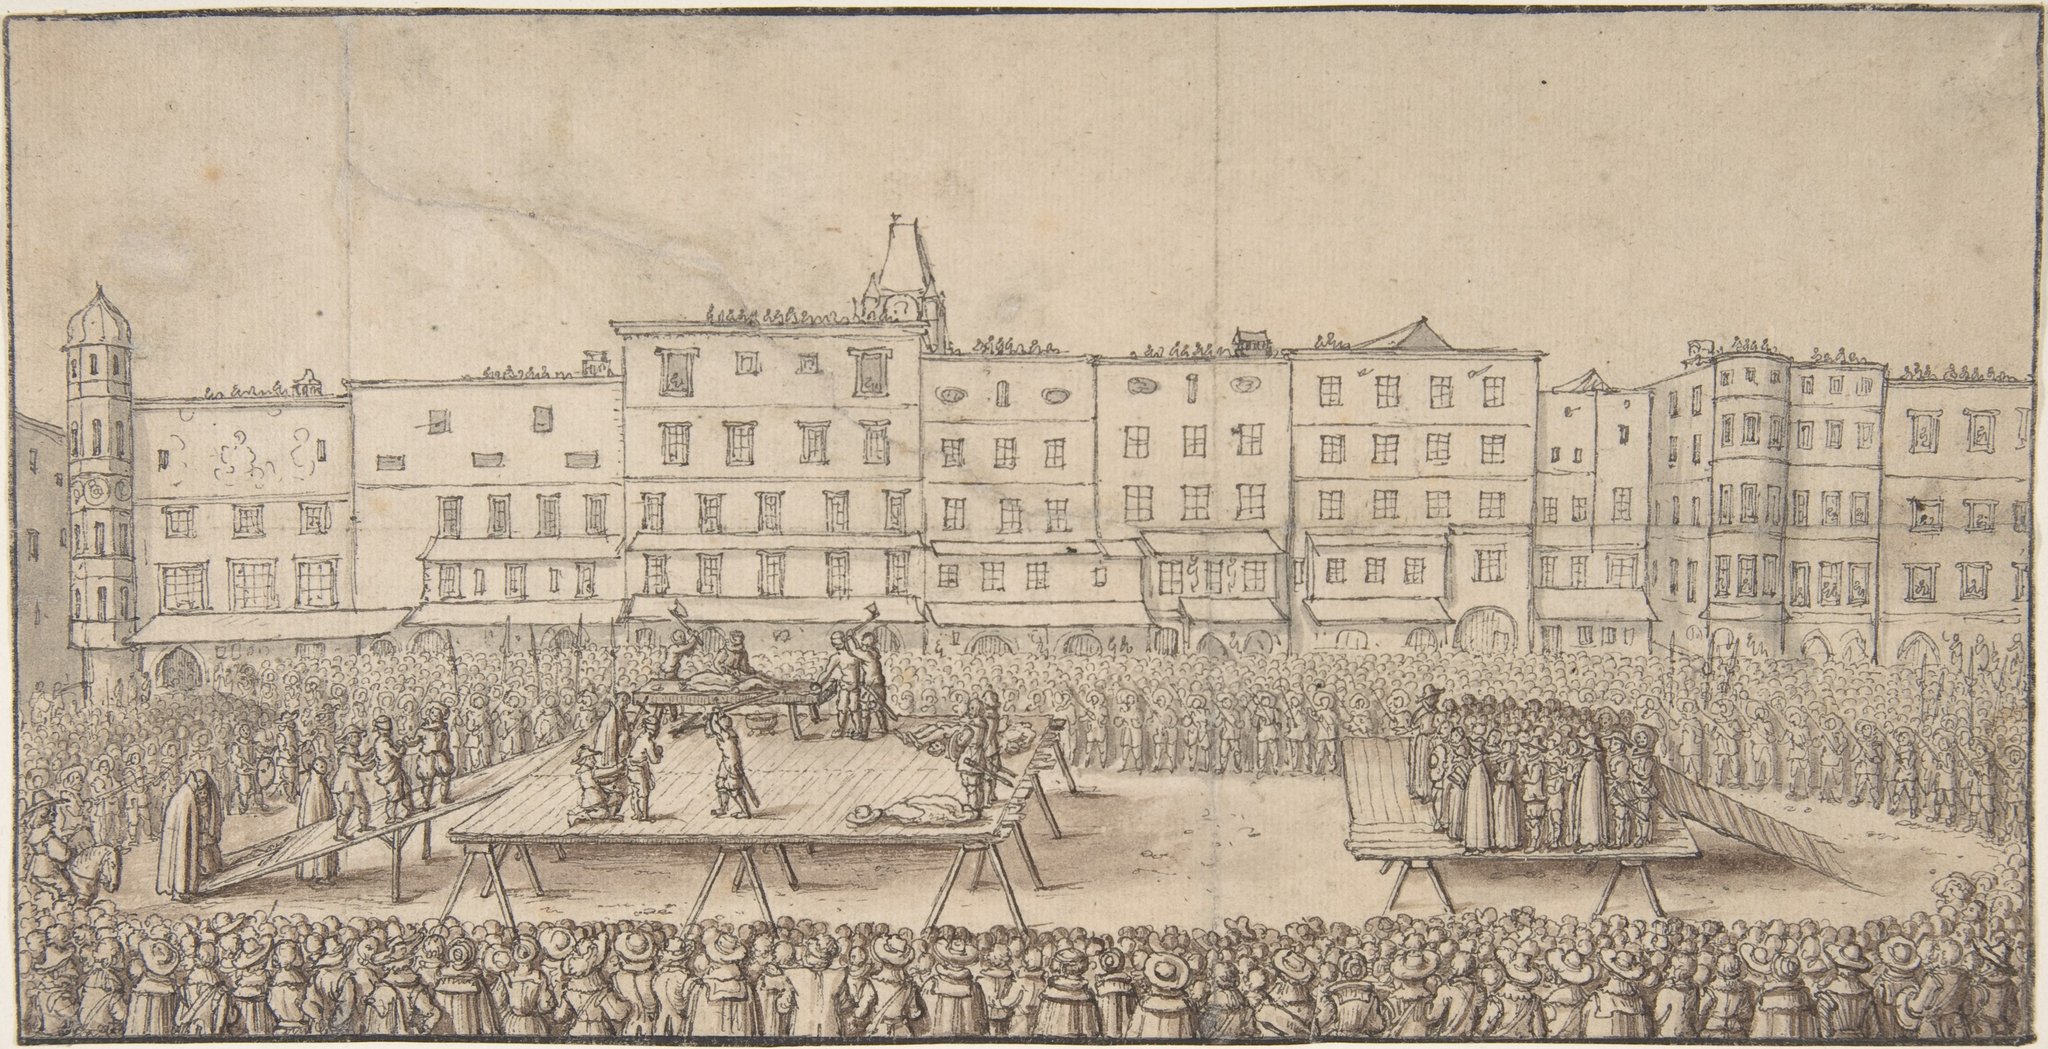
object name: drawing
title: An Execution of Seven Boores Rebels in Lintz, June 16, 1636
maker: Anonymous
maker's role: artist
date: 1636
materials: ink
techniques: pen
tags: buildings,men,crowd,punishment